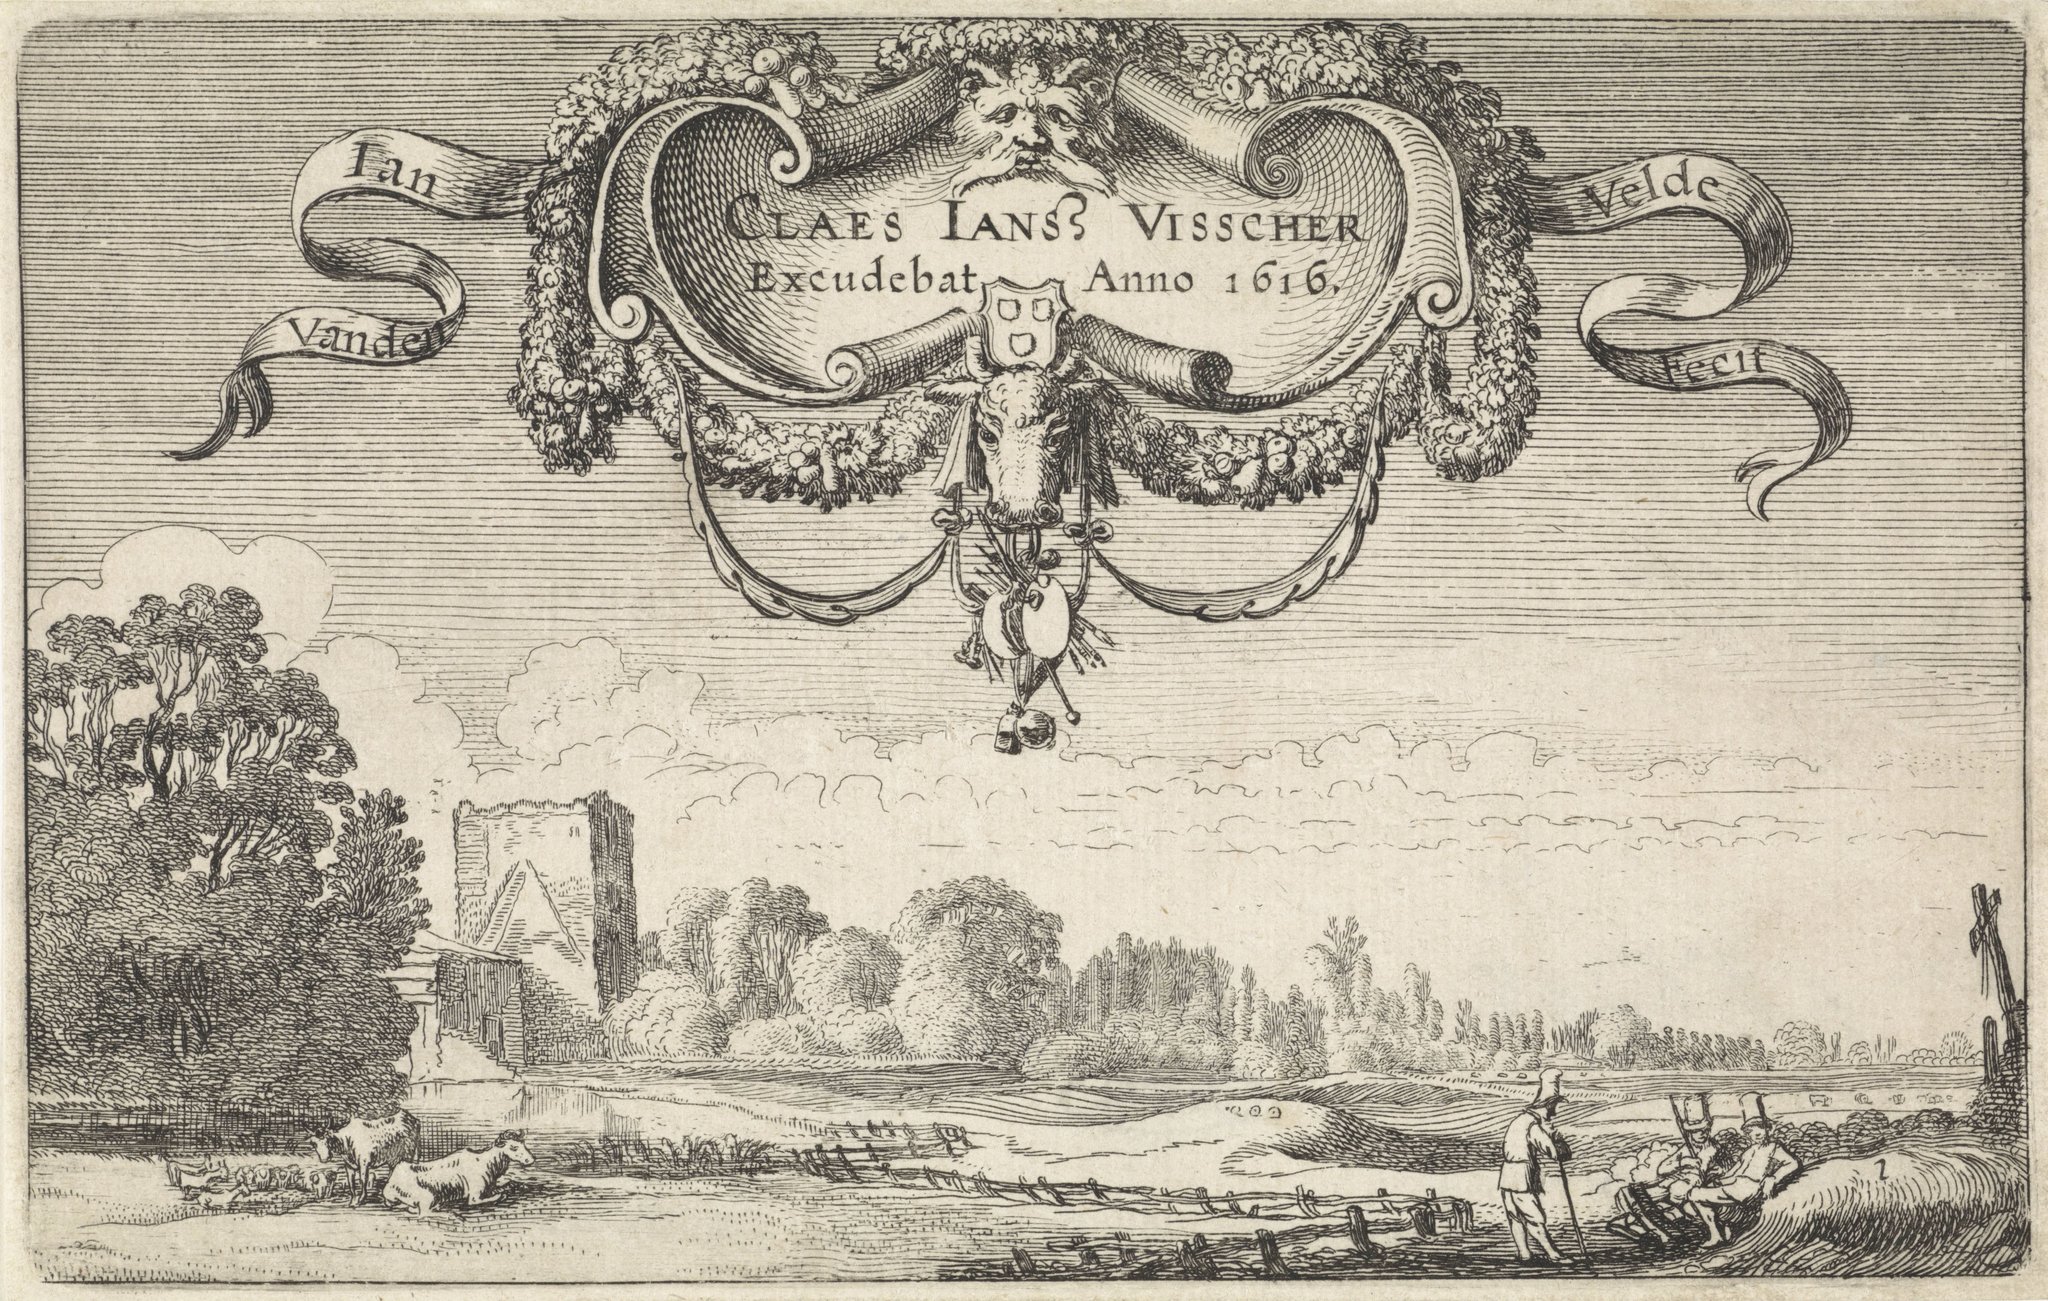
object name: titelprent, frontispice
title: Amenissimae aliquot requculae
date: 1616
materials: paper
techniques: etching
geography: northern netherlands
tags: cow, landscape with ruins, landscape with tower or castle, tower (of house or building), resting - bb - out of doors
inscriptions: collector's mark: Lugt 964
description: Rustende figuren in een landschap met koeien en een toren. Bovenaan een cartouche met de titel. Onderaan de cartouche een kop van een stier waaraan schildersattributen als verwijzing naar de heilige Lucas als patroonheilige van de kunstenaars. Bovenaan een kop van een sater. Titelprent van deel twee van een serie van in totaal 52 prenten met landschappen, verdeeld over twee delen van elk 26 prenten.